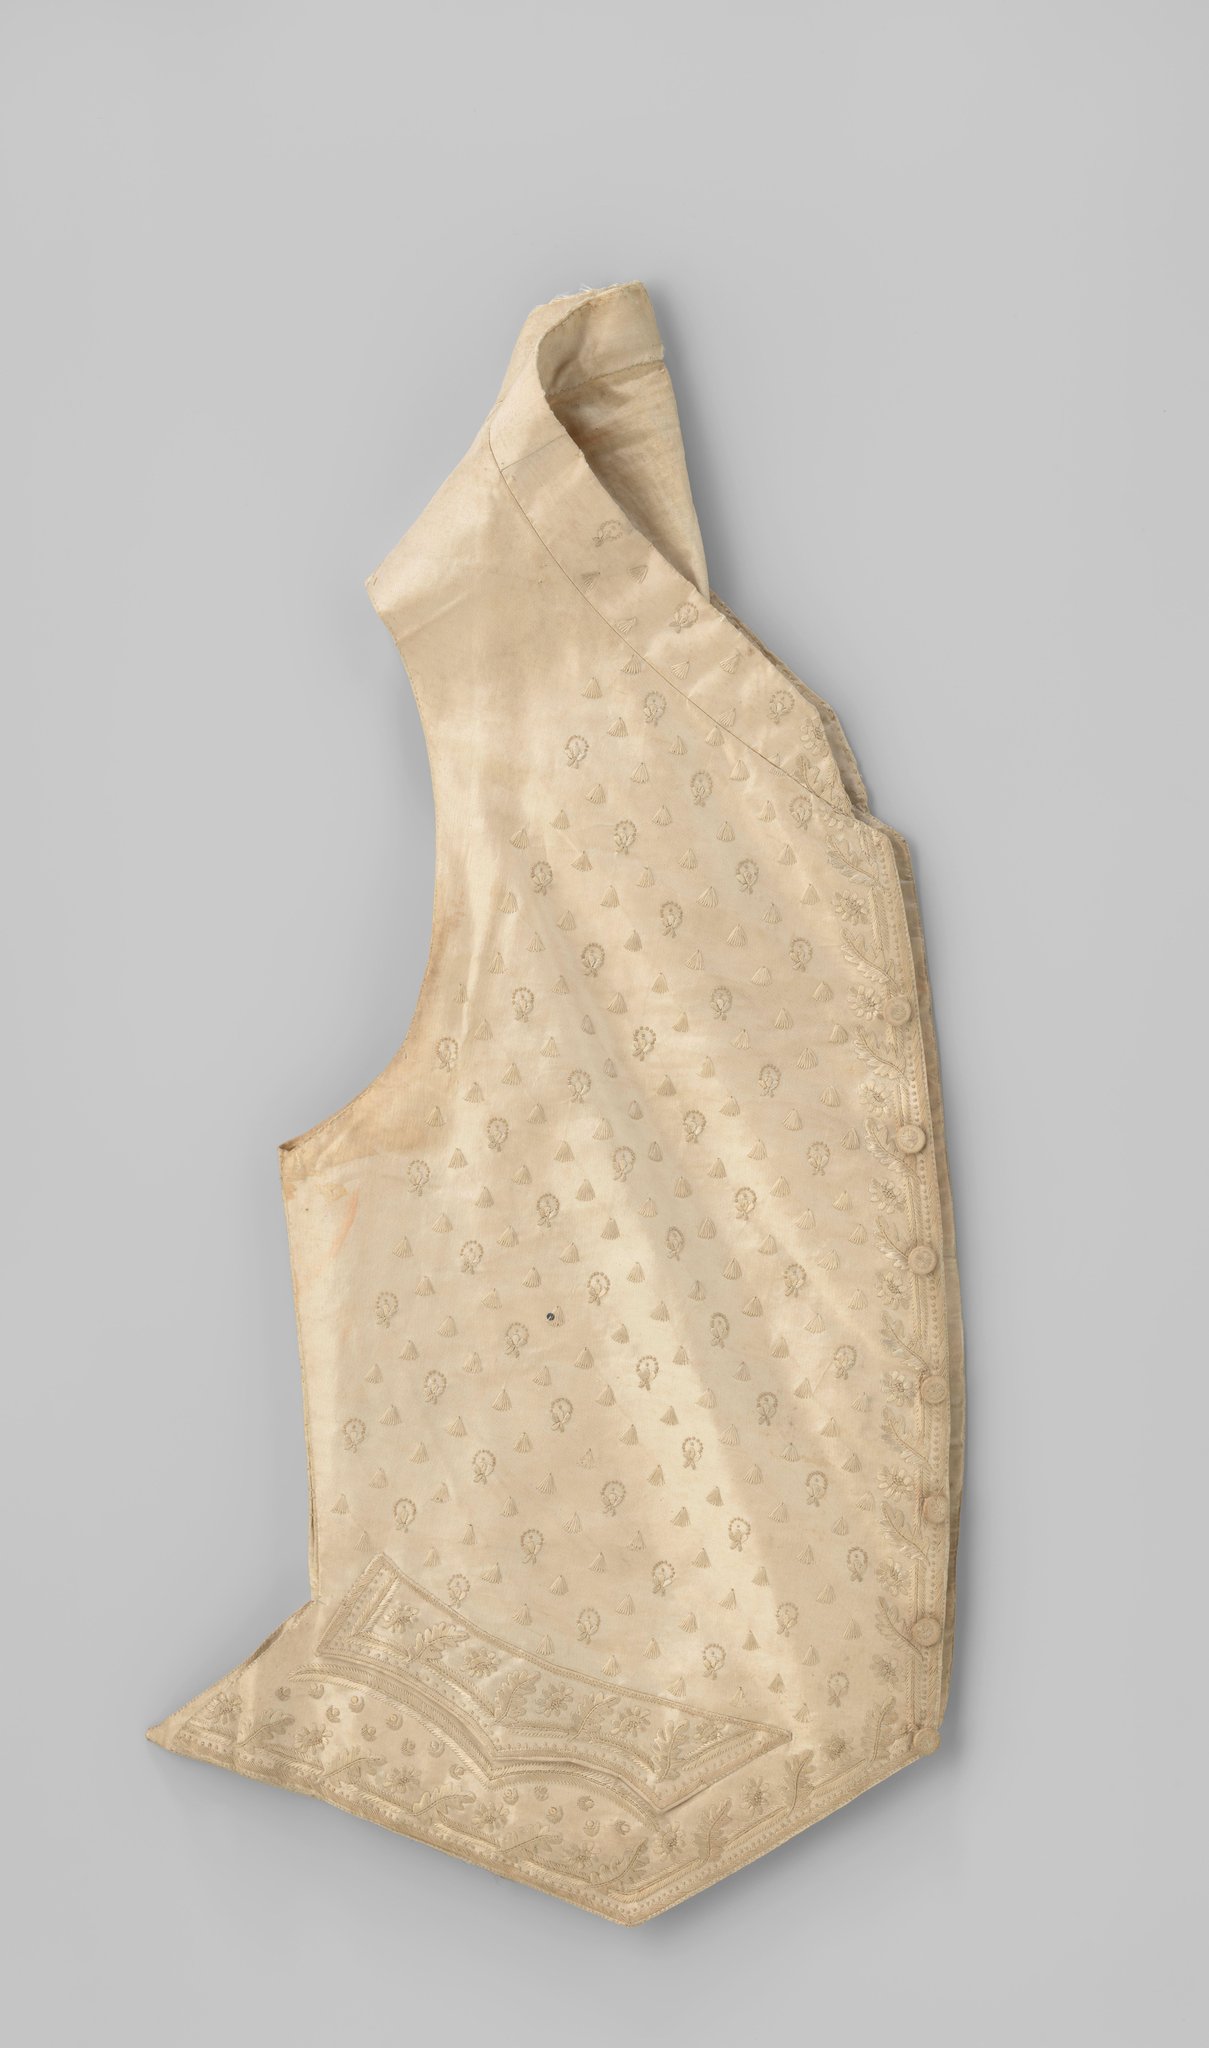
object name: vest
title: Vest van crème zijde, in crème geborduurd met een strooimotief van kwasten en kransen en een randmotief van bladerranken, waartussen losstaande bloemen.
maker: Anonymous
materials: cotton, silk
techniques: embroidered